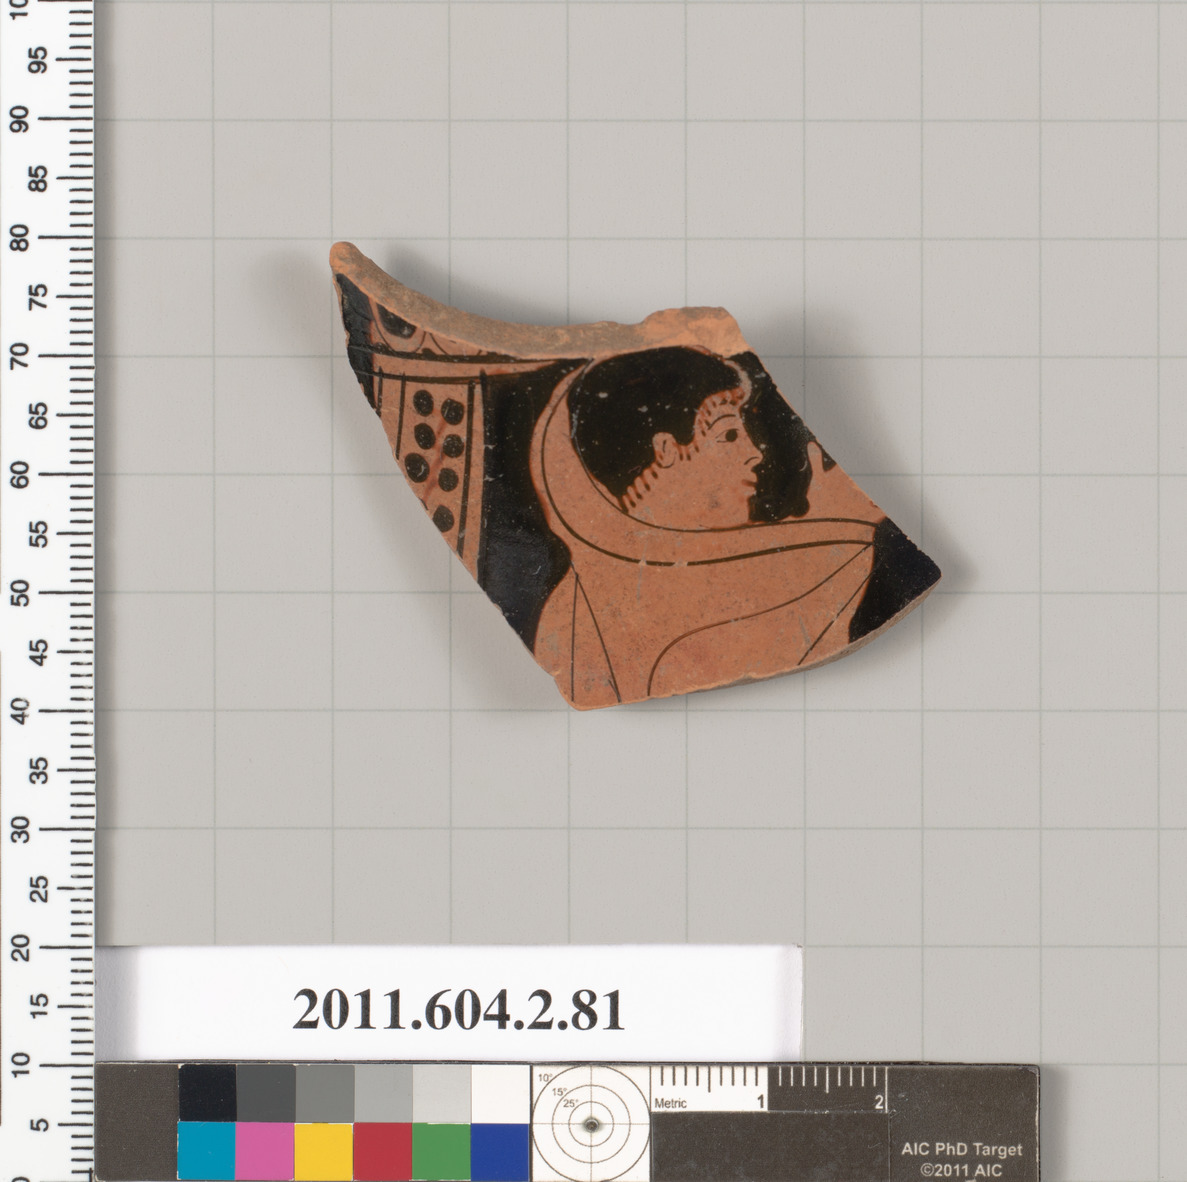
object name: pelike fragment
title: Terracotta fragment of a pelike (jar)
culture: greek, attic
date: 475-451 BCE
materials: terracotta